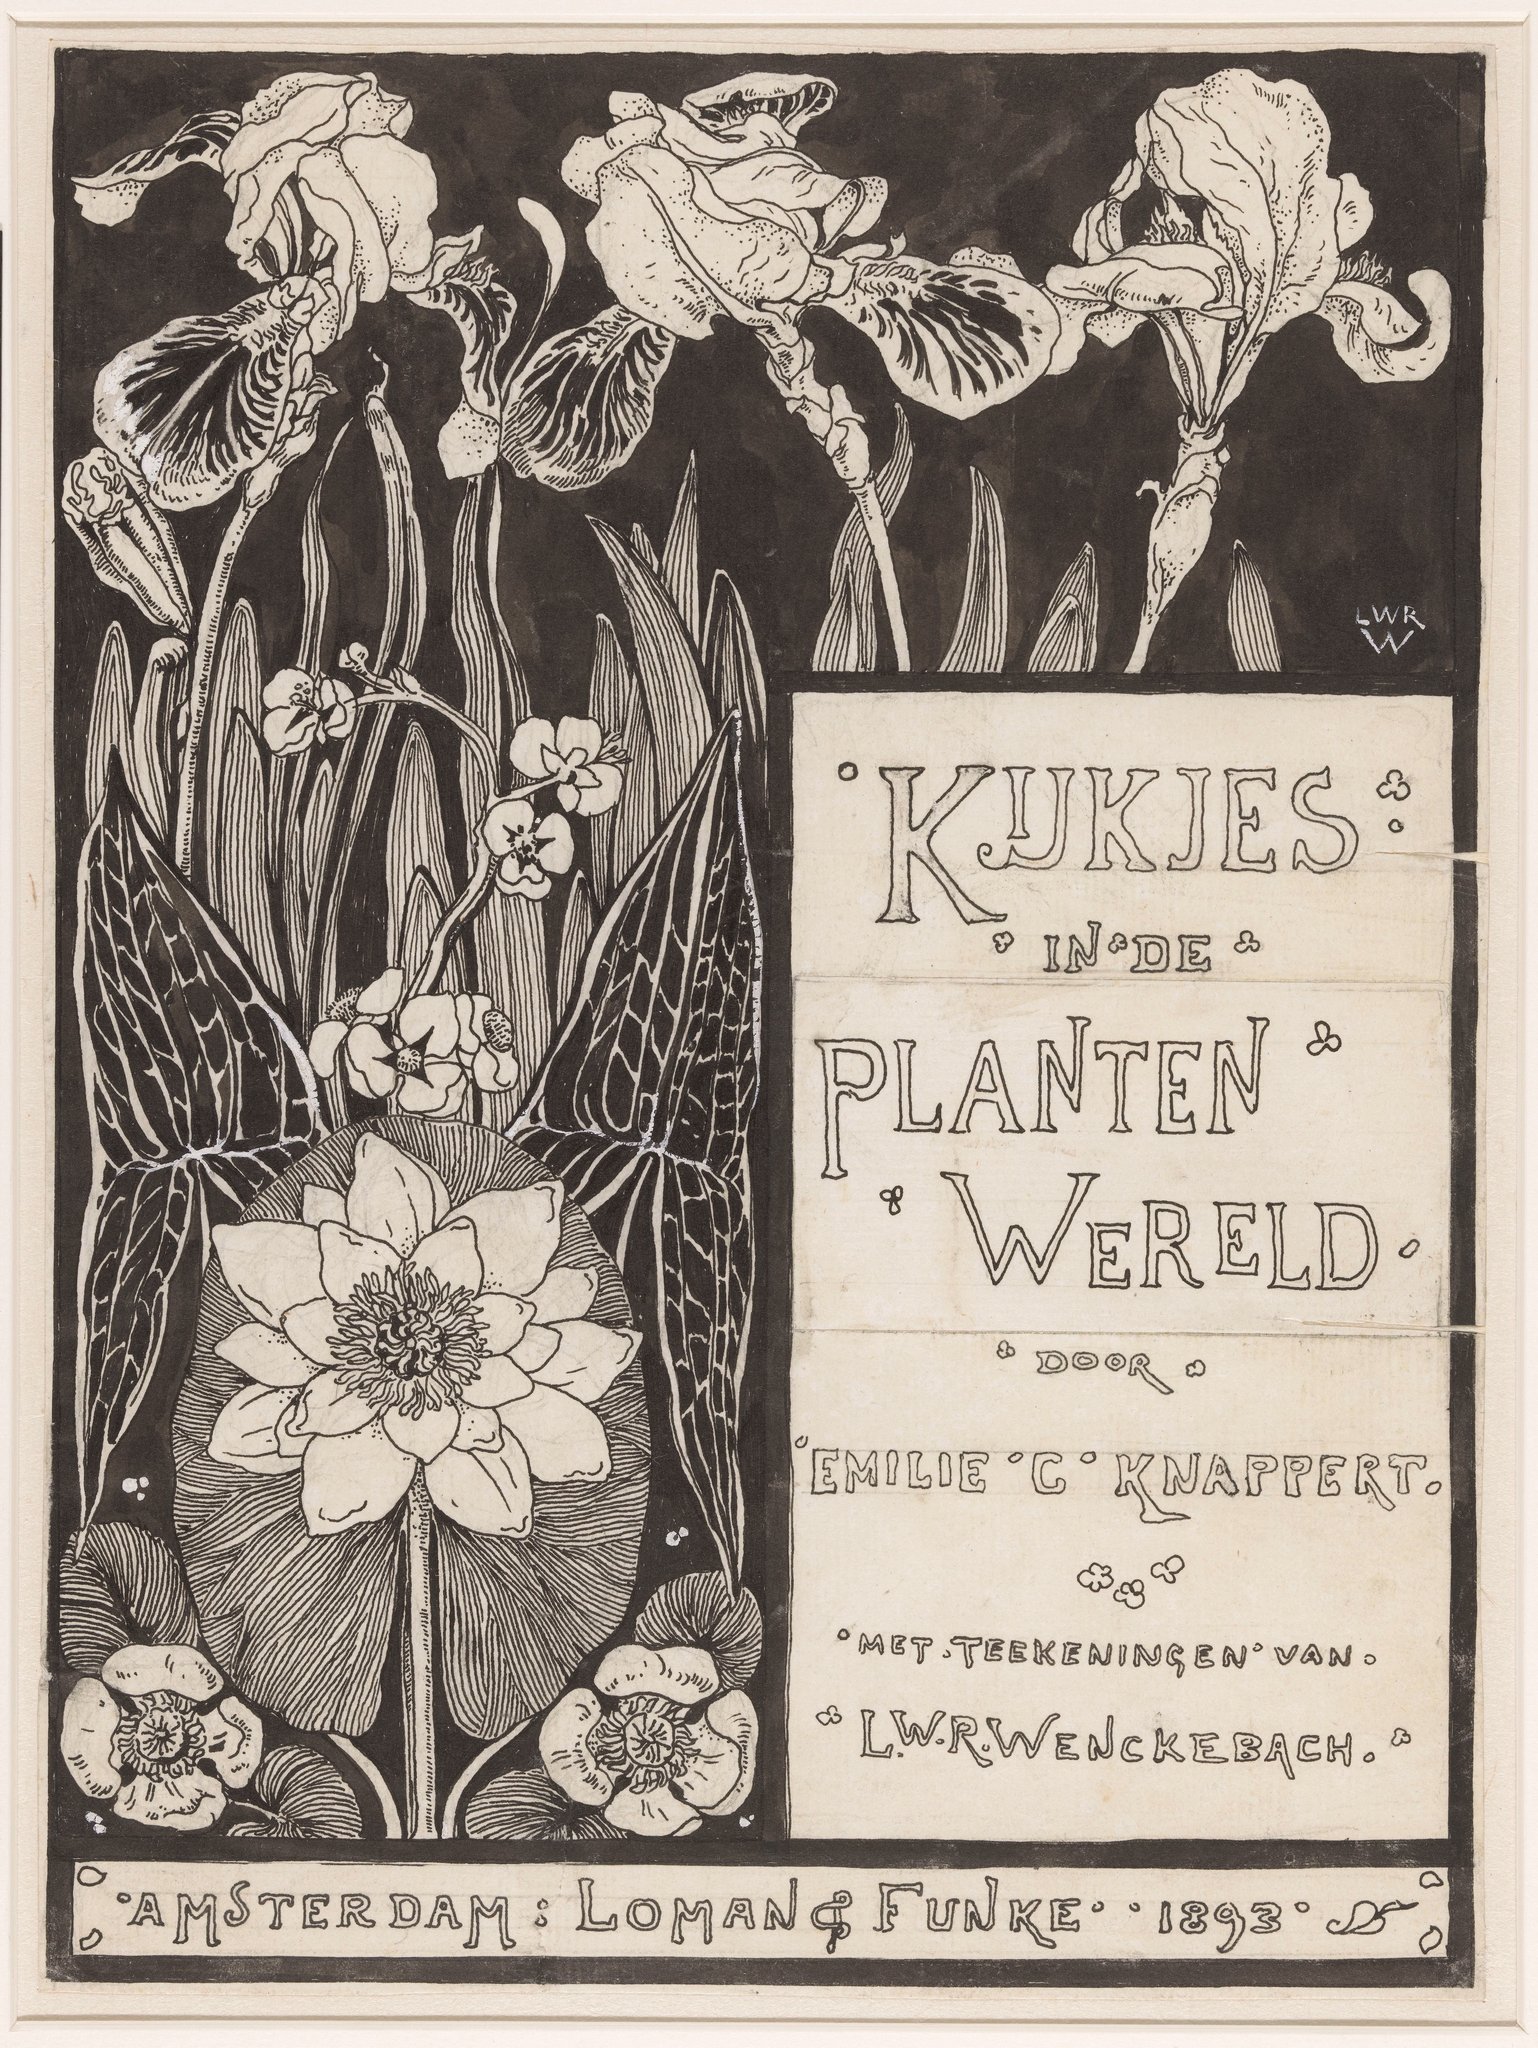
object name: drawing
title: Bandontwerp voor: Knappert, Emilie C., Kijkjes in de plantenwereld, 1893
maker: willem wenckebach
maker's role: designer, draughtsman, painter, print maker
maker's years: 1860-1937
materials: paint, ink, paper, pencil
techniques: brush, pen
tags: flowers, flowers: water-lily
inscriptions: collector's mark: Lugt 2228a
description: Bandontwerp voor: Knappert, Emilie C. Kijkjes in de plantenwereld. Loman & Funke: Amsterdam, 1893.